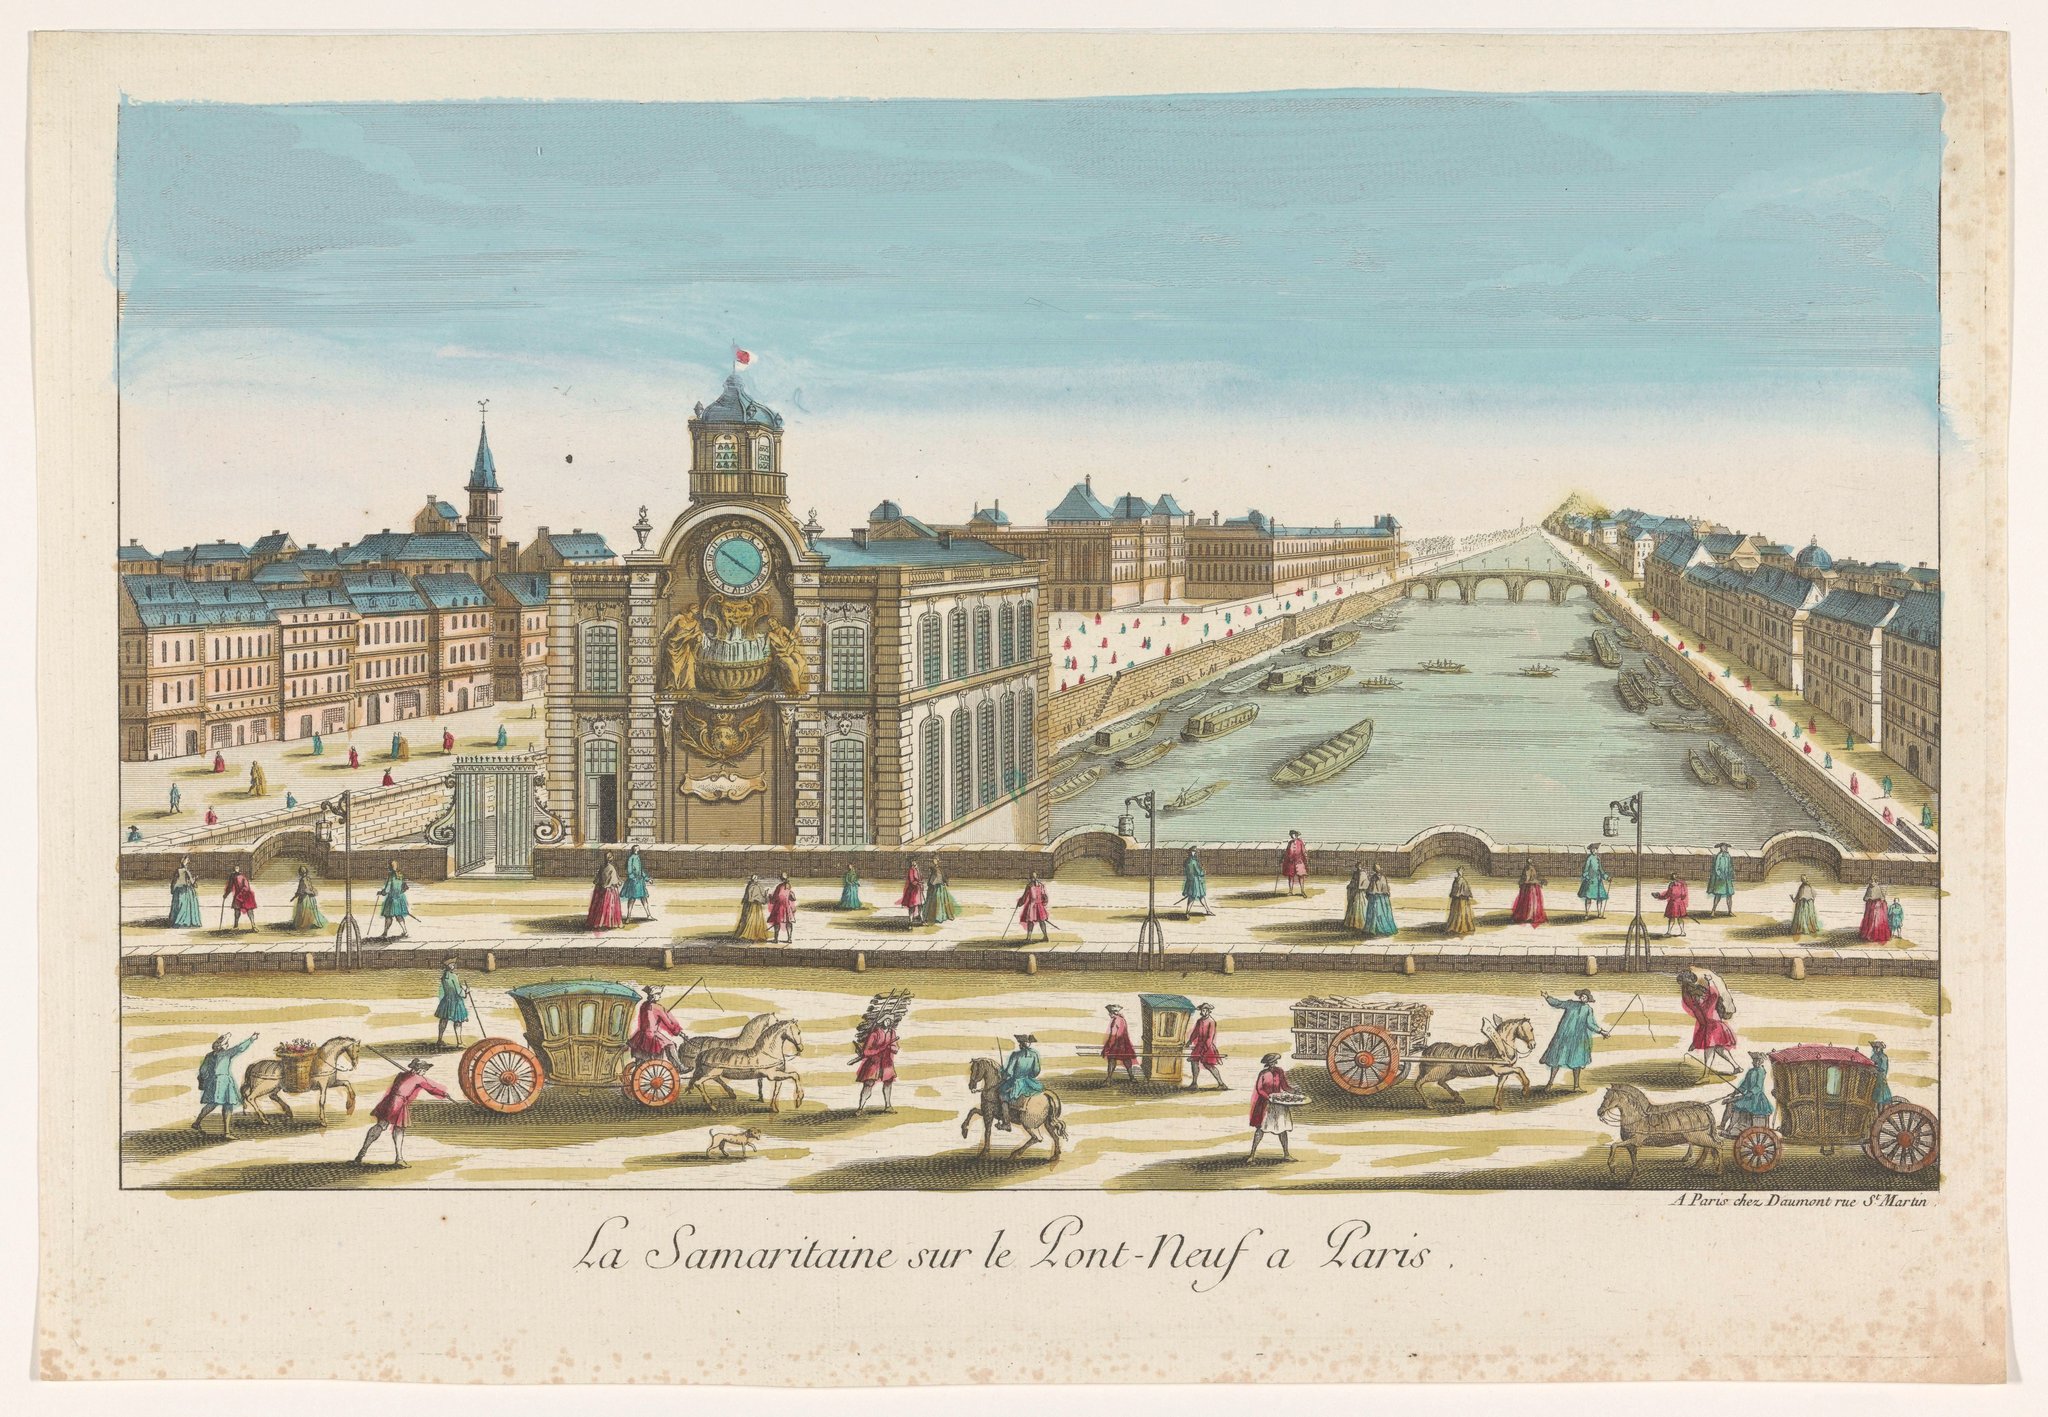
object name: opticaprent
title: Gezicht op de waterpomp Samaritaine op de Pont Neuf over de rivier de Seine te Parijs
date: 1745-1775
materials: paper, watercolor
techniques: brush, etching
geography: france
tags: bridge in city across river, canal, etc. (+ city(-scape) with figures, staffage), christ and the woman of samaria: sitting at jacob's well he asks her for a drink from her jug, pump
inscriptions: collector's mark: Lugt 2233, watermark